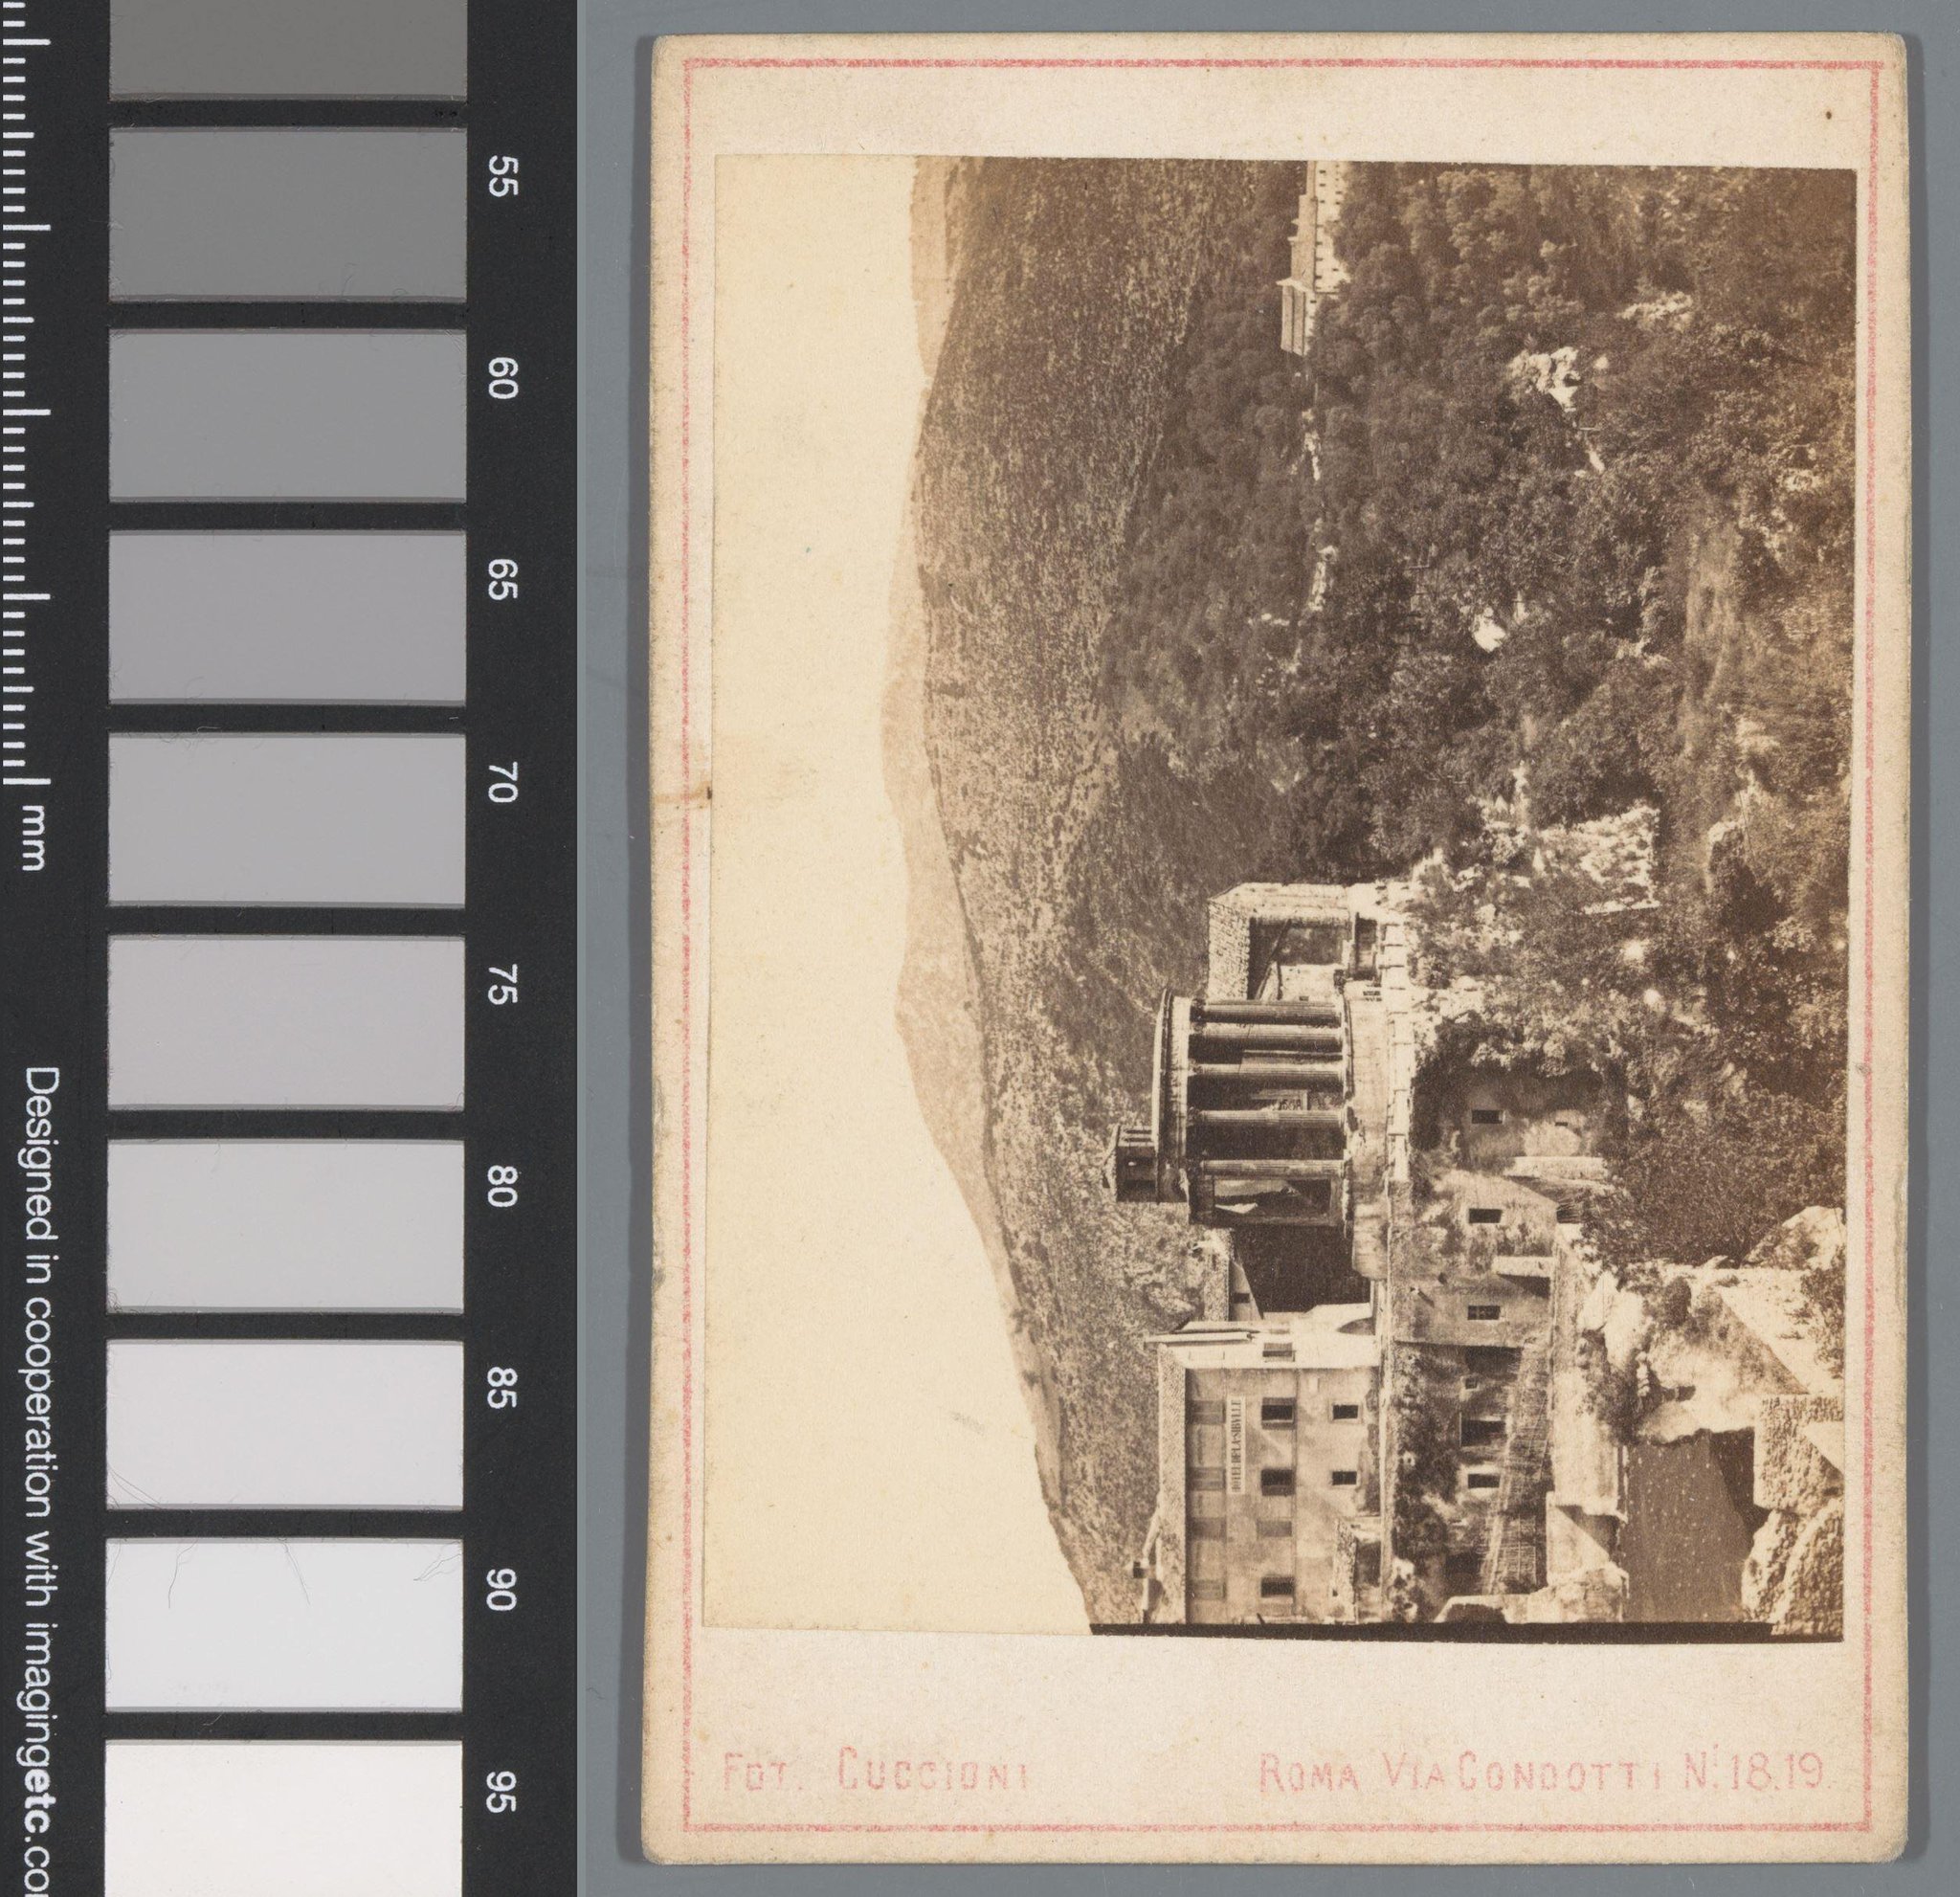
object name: carte de visite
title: Tivoli, temple de Vesta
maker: tomasso cuccioni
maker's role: print maker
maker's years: 1790-1864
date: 1855-1885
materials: cardboard, paper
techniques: albumen print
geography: tivoli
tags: landscape with ruins, temple, shrine ~ roman religion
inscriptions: inscription: ‘Roma Via Condotti Ni. 18.19.’, inscription: ‘Ticoli. Temple de Vesta’